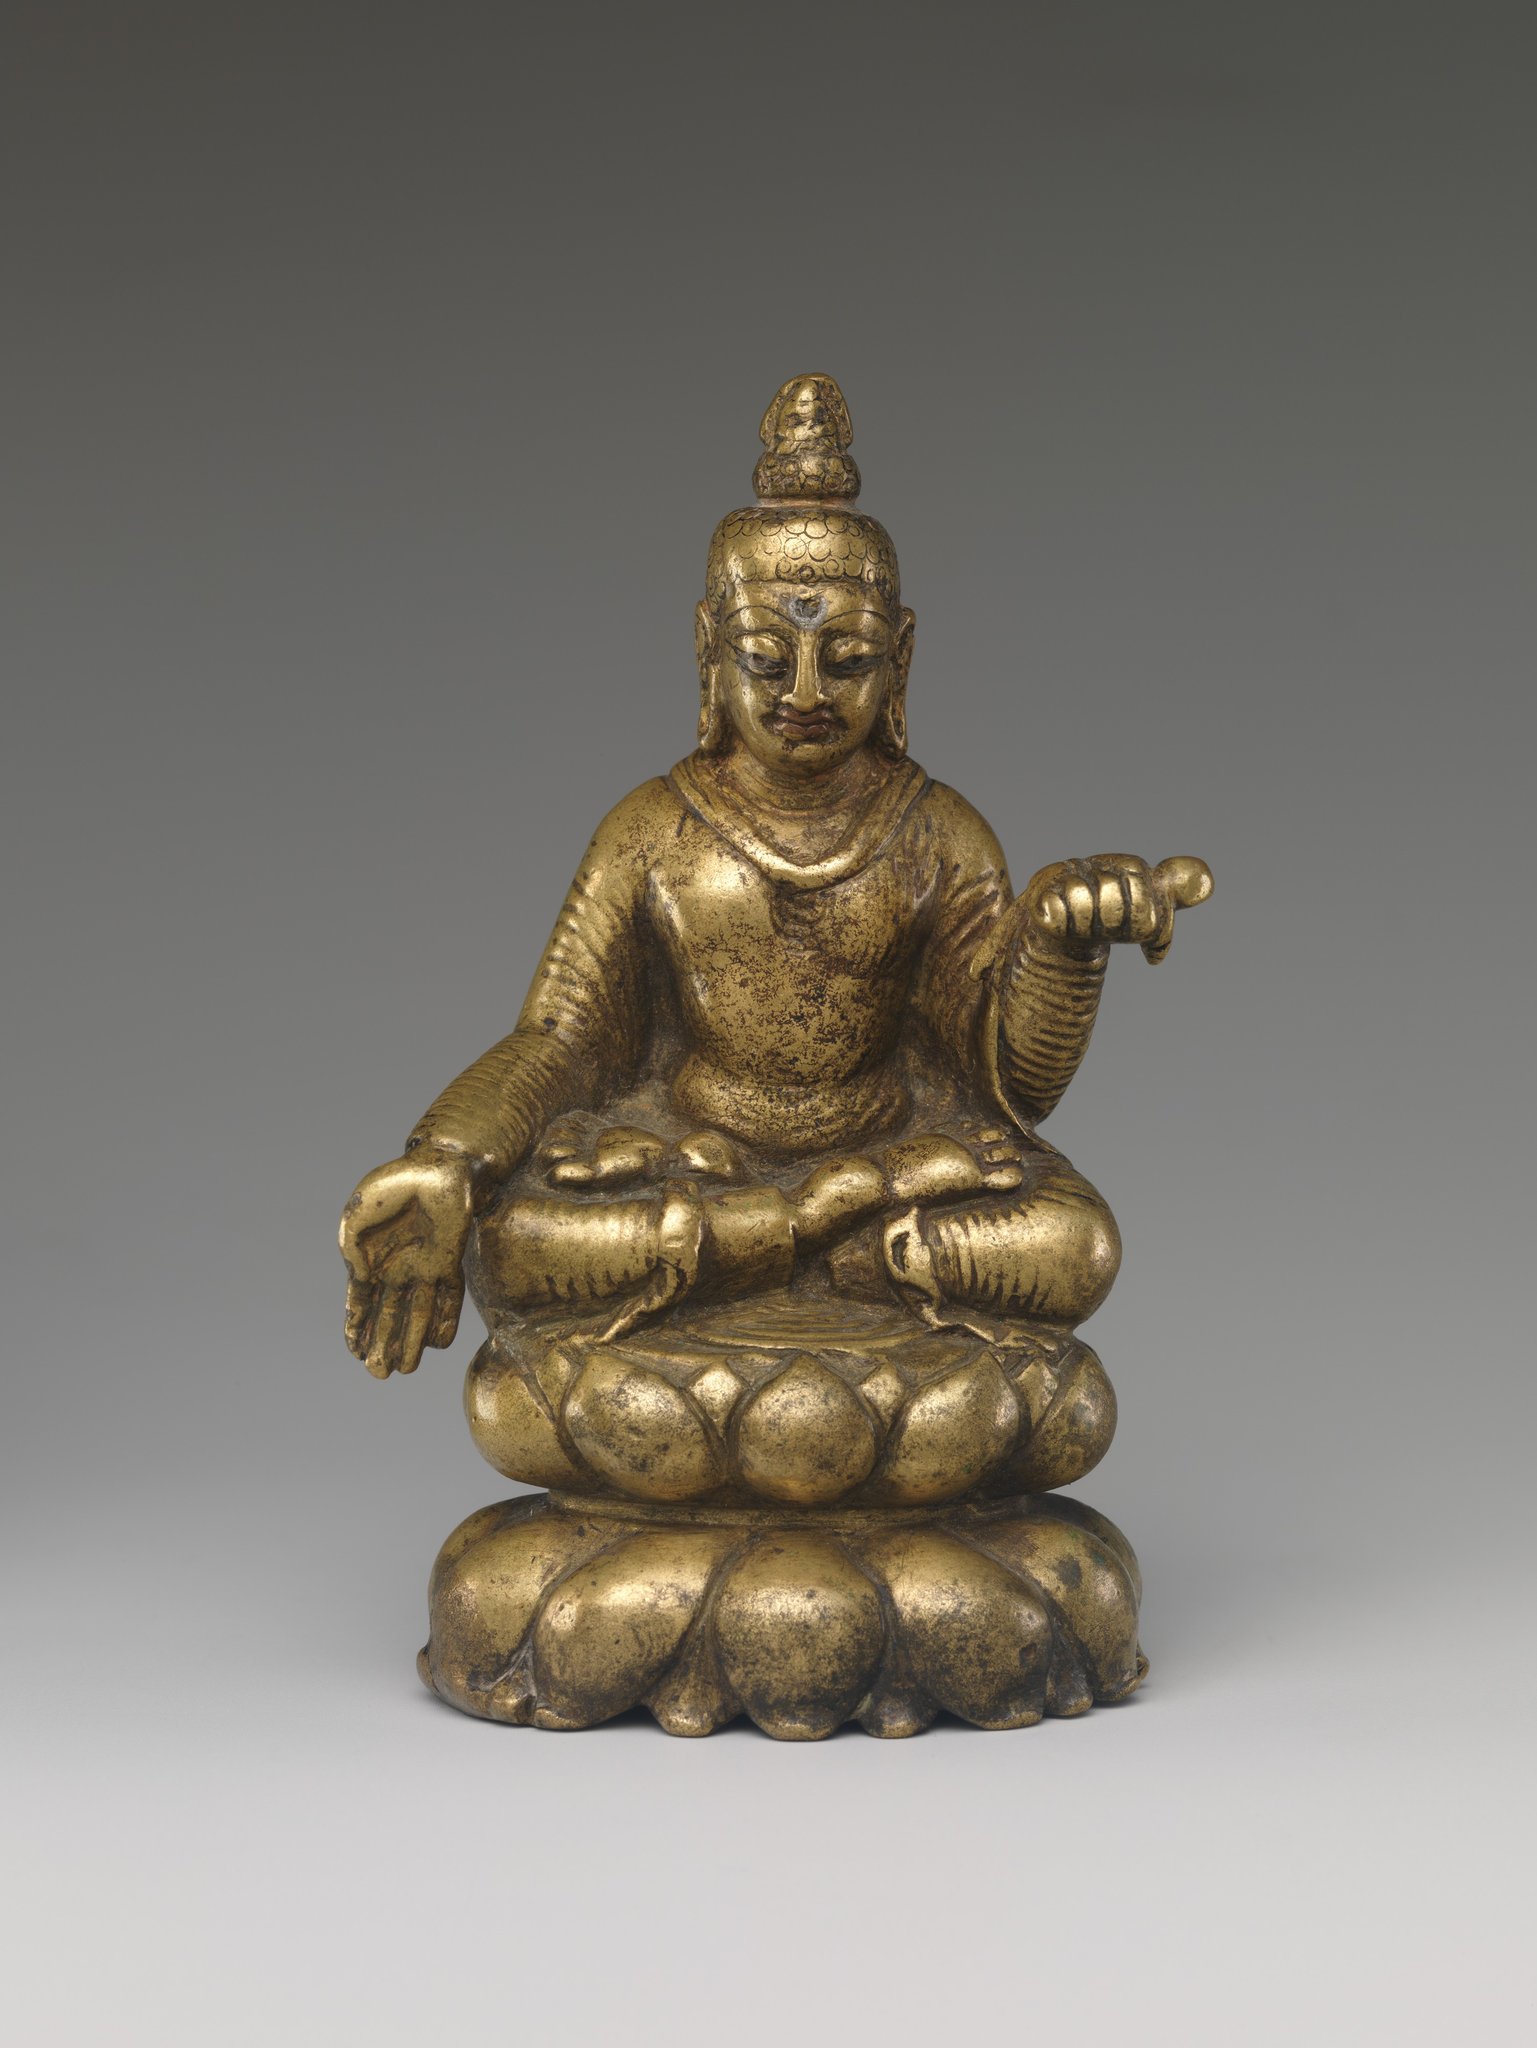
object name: figurine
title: Seated Buddha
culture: indian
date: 601-800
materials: brass, copper, silver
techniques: inlay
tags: kashmir,buddhism,buddha